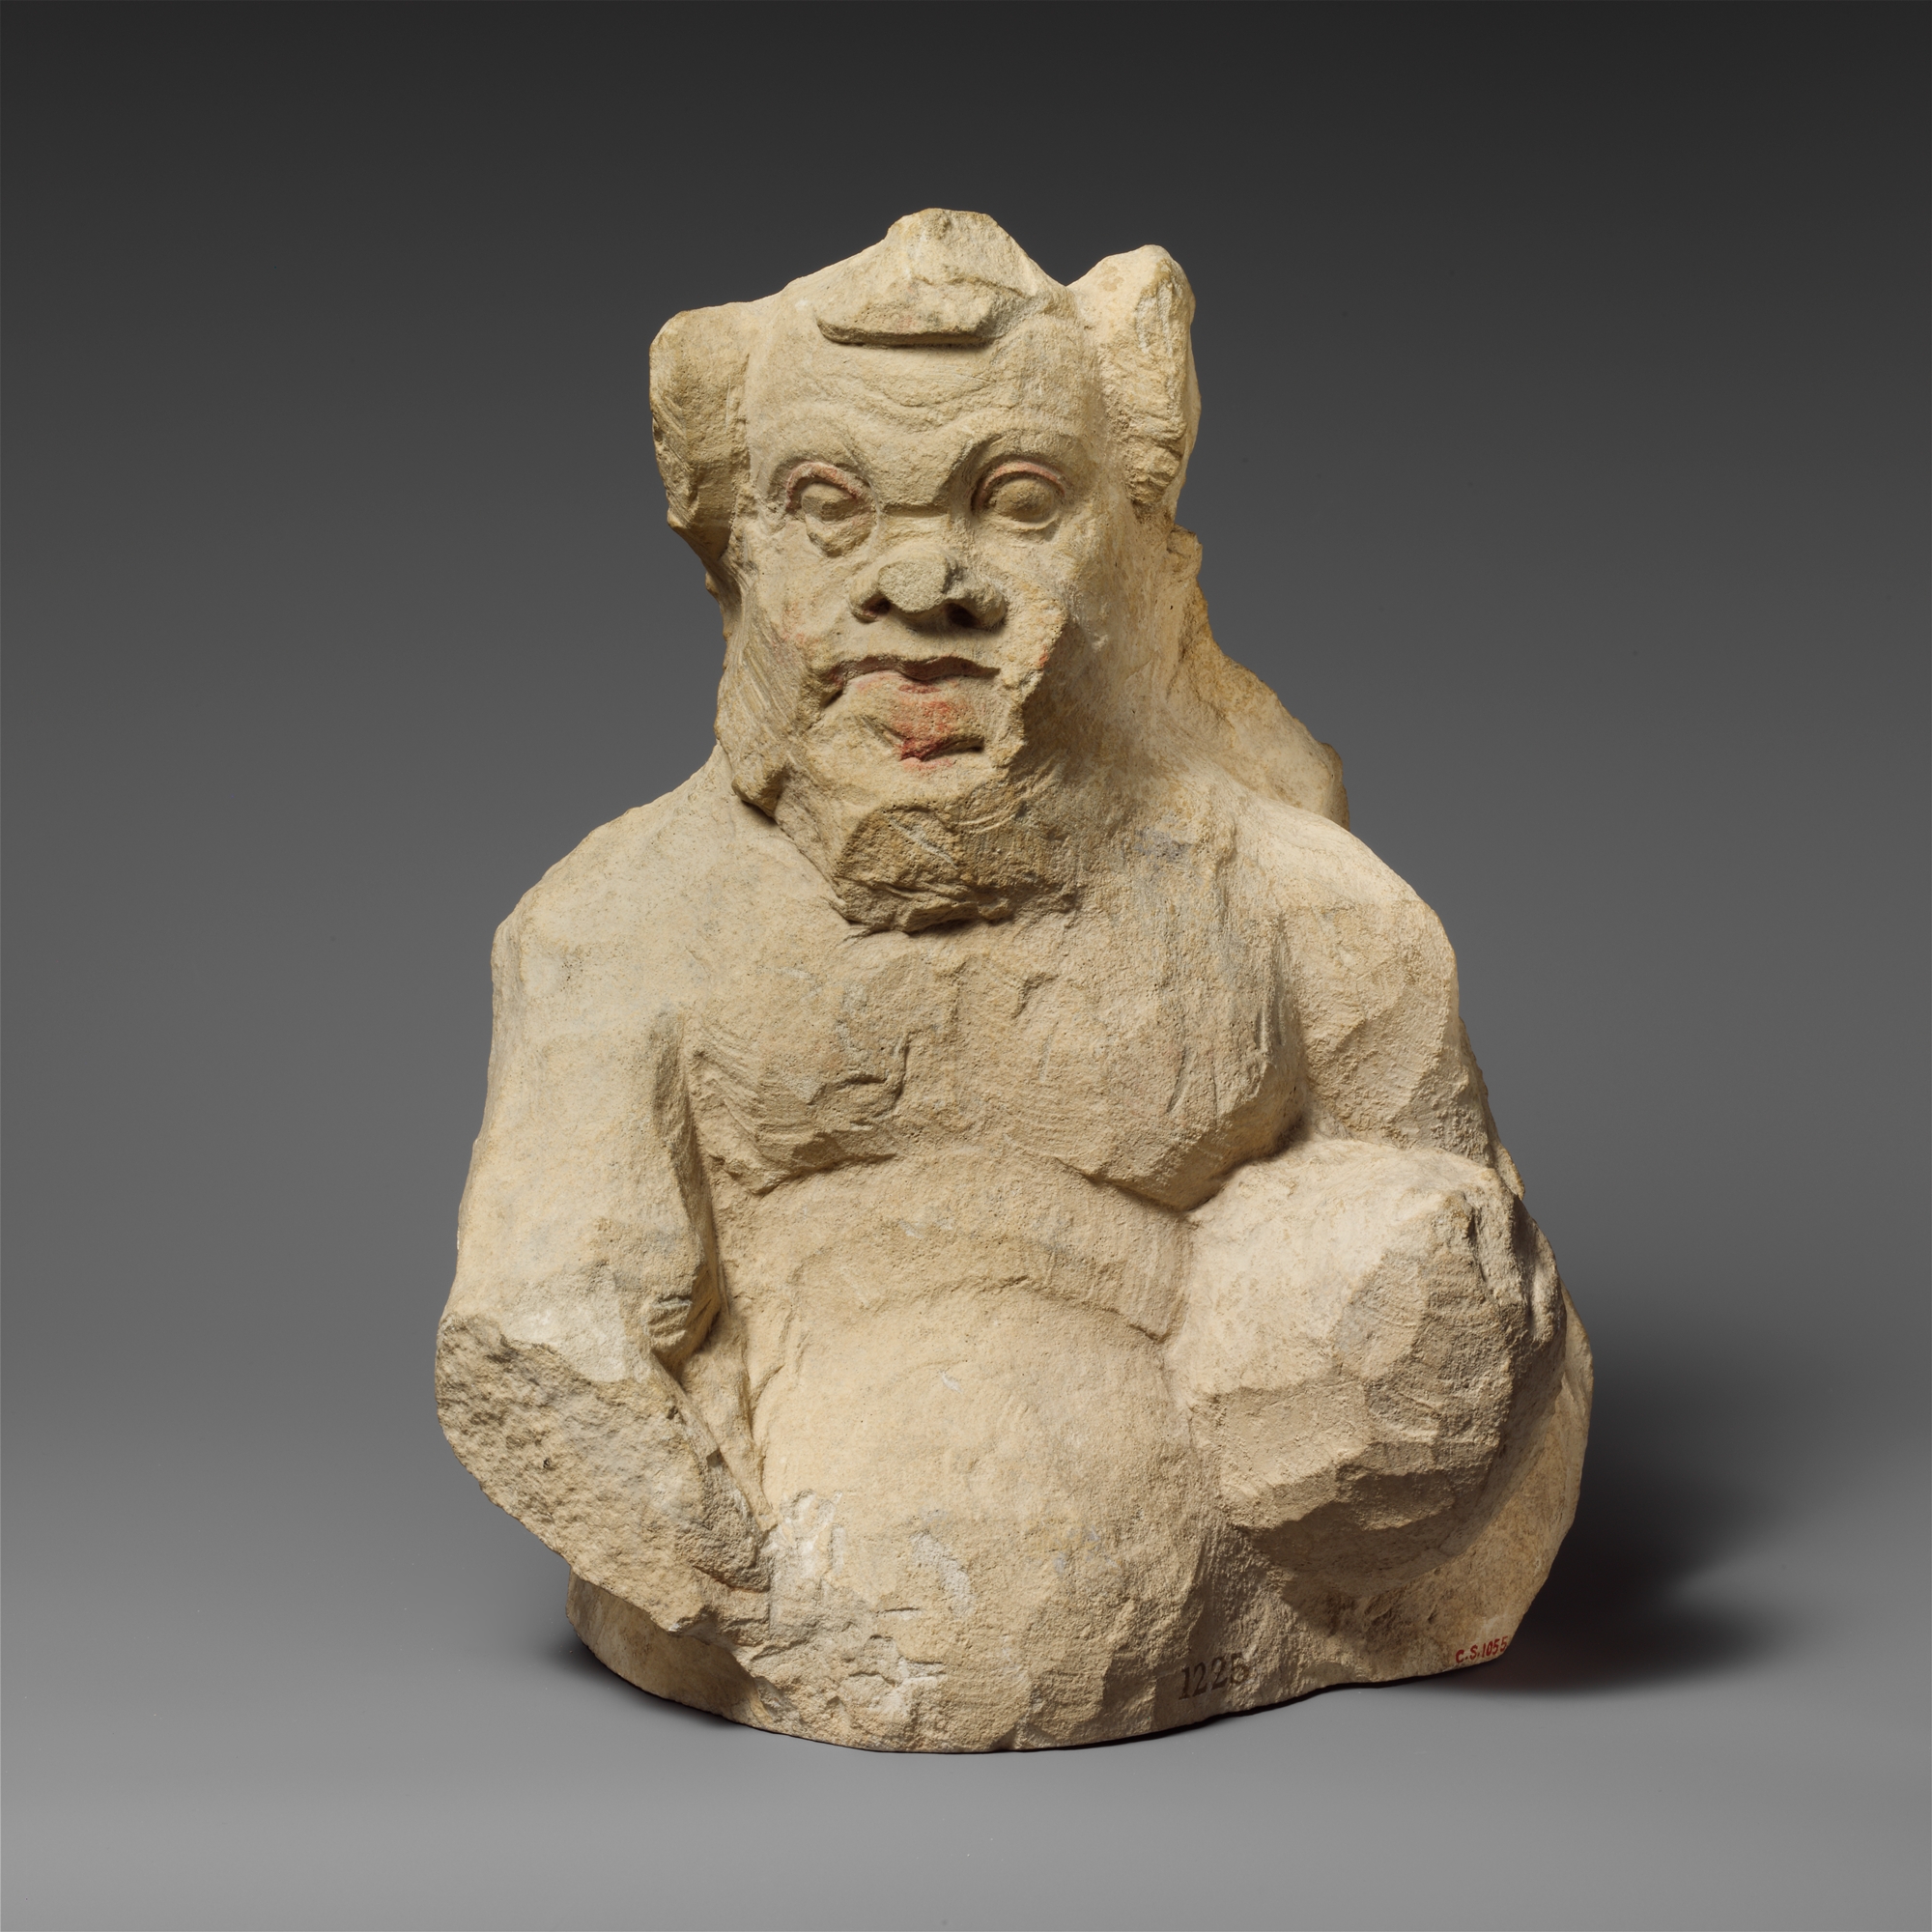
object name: head and torso of silenos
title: Fragment of a partly unfinished limestone statuette of a silen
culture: cypriot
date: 330-30 BCE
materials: limestone